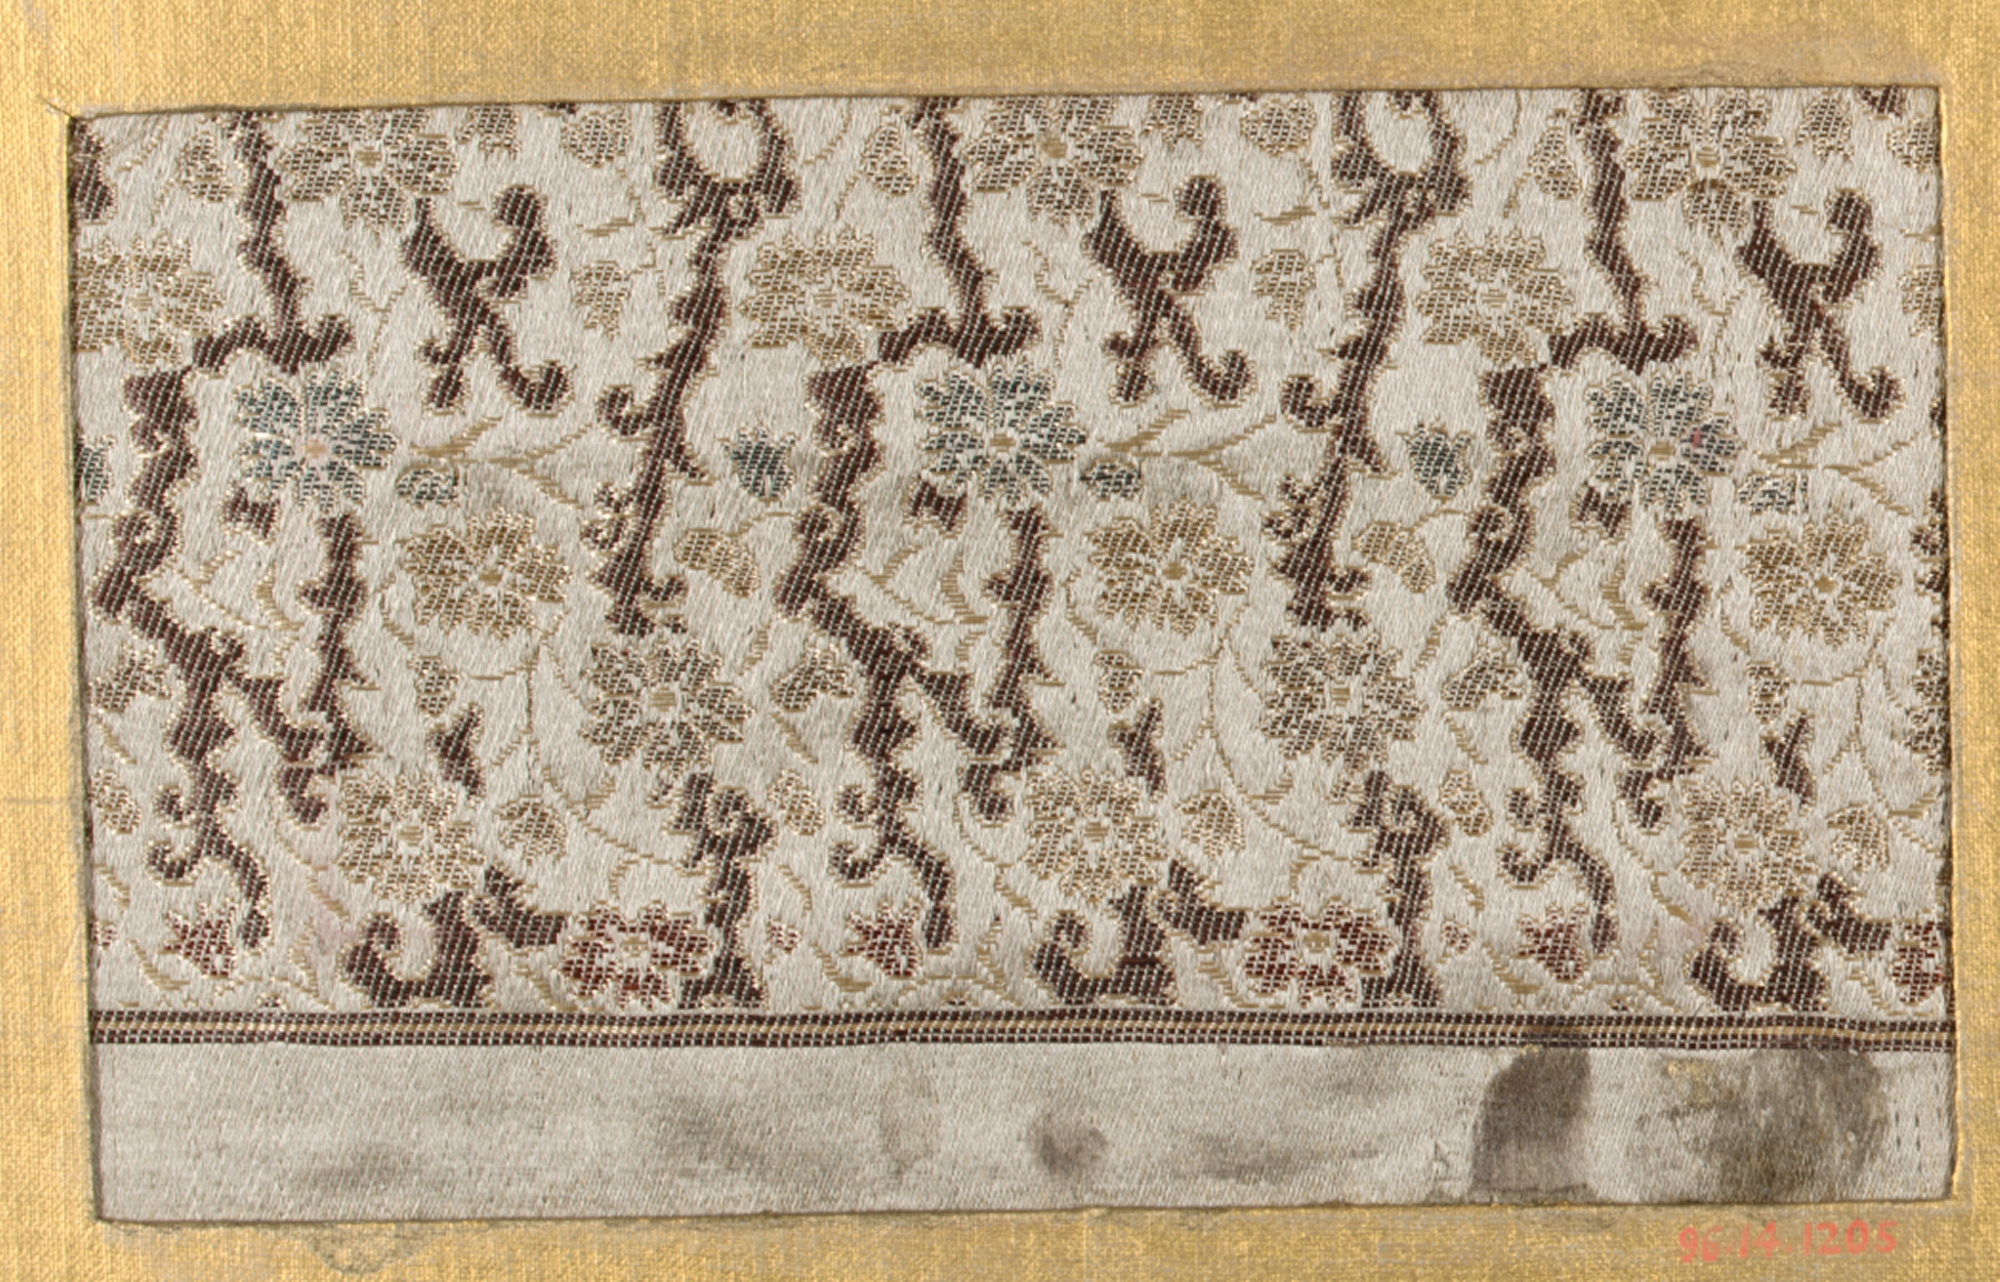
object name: piece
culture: japanese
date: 1701-1900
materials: silk